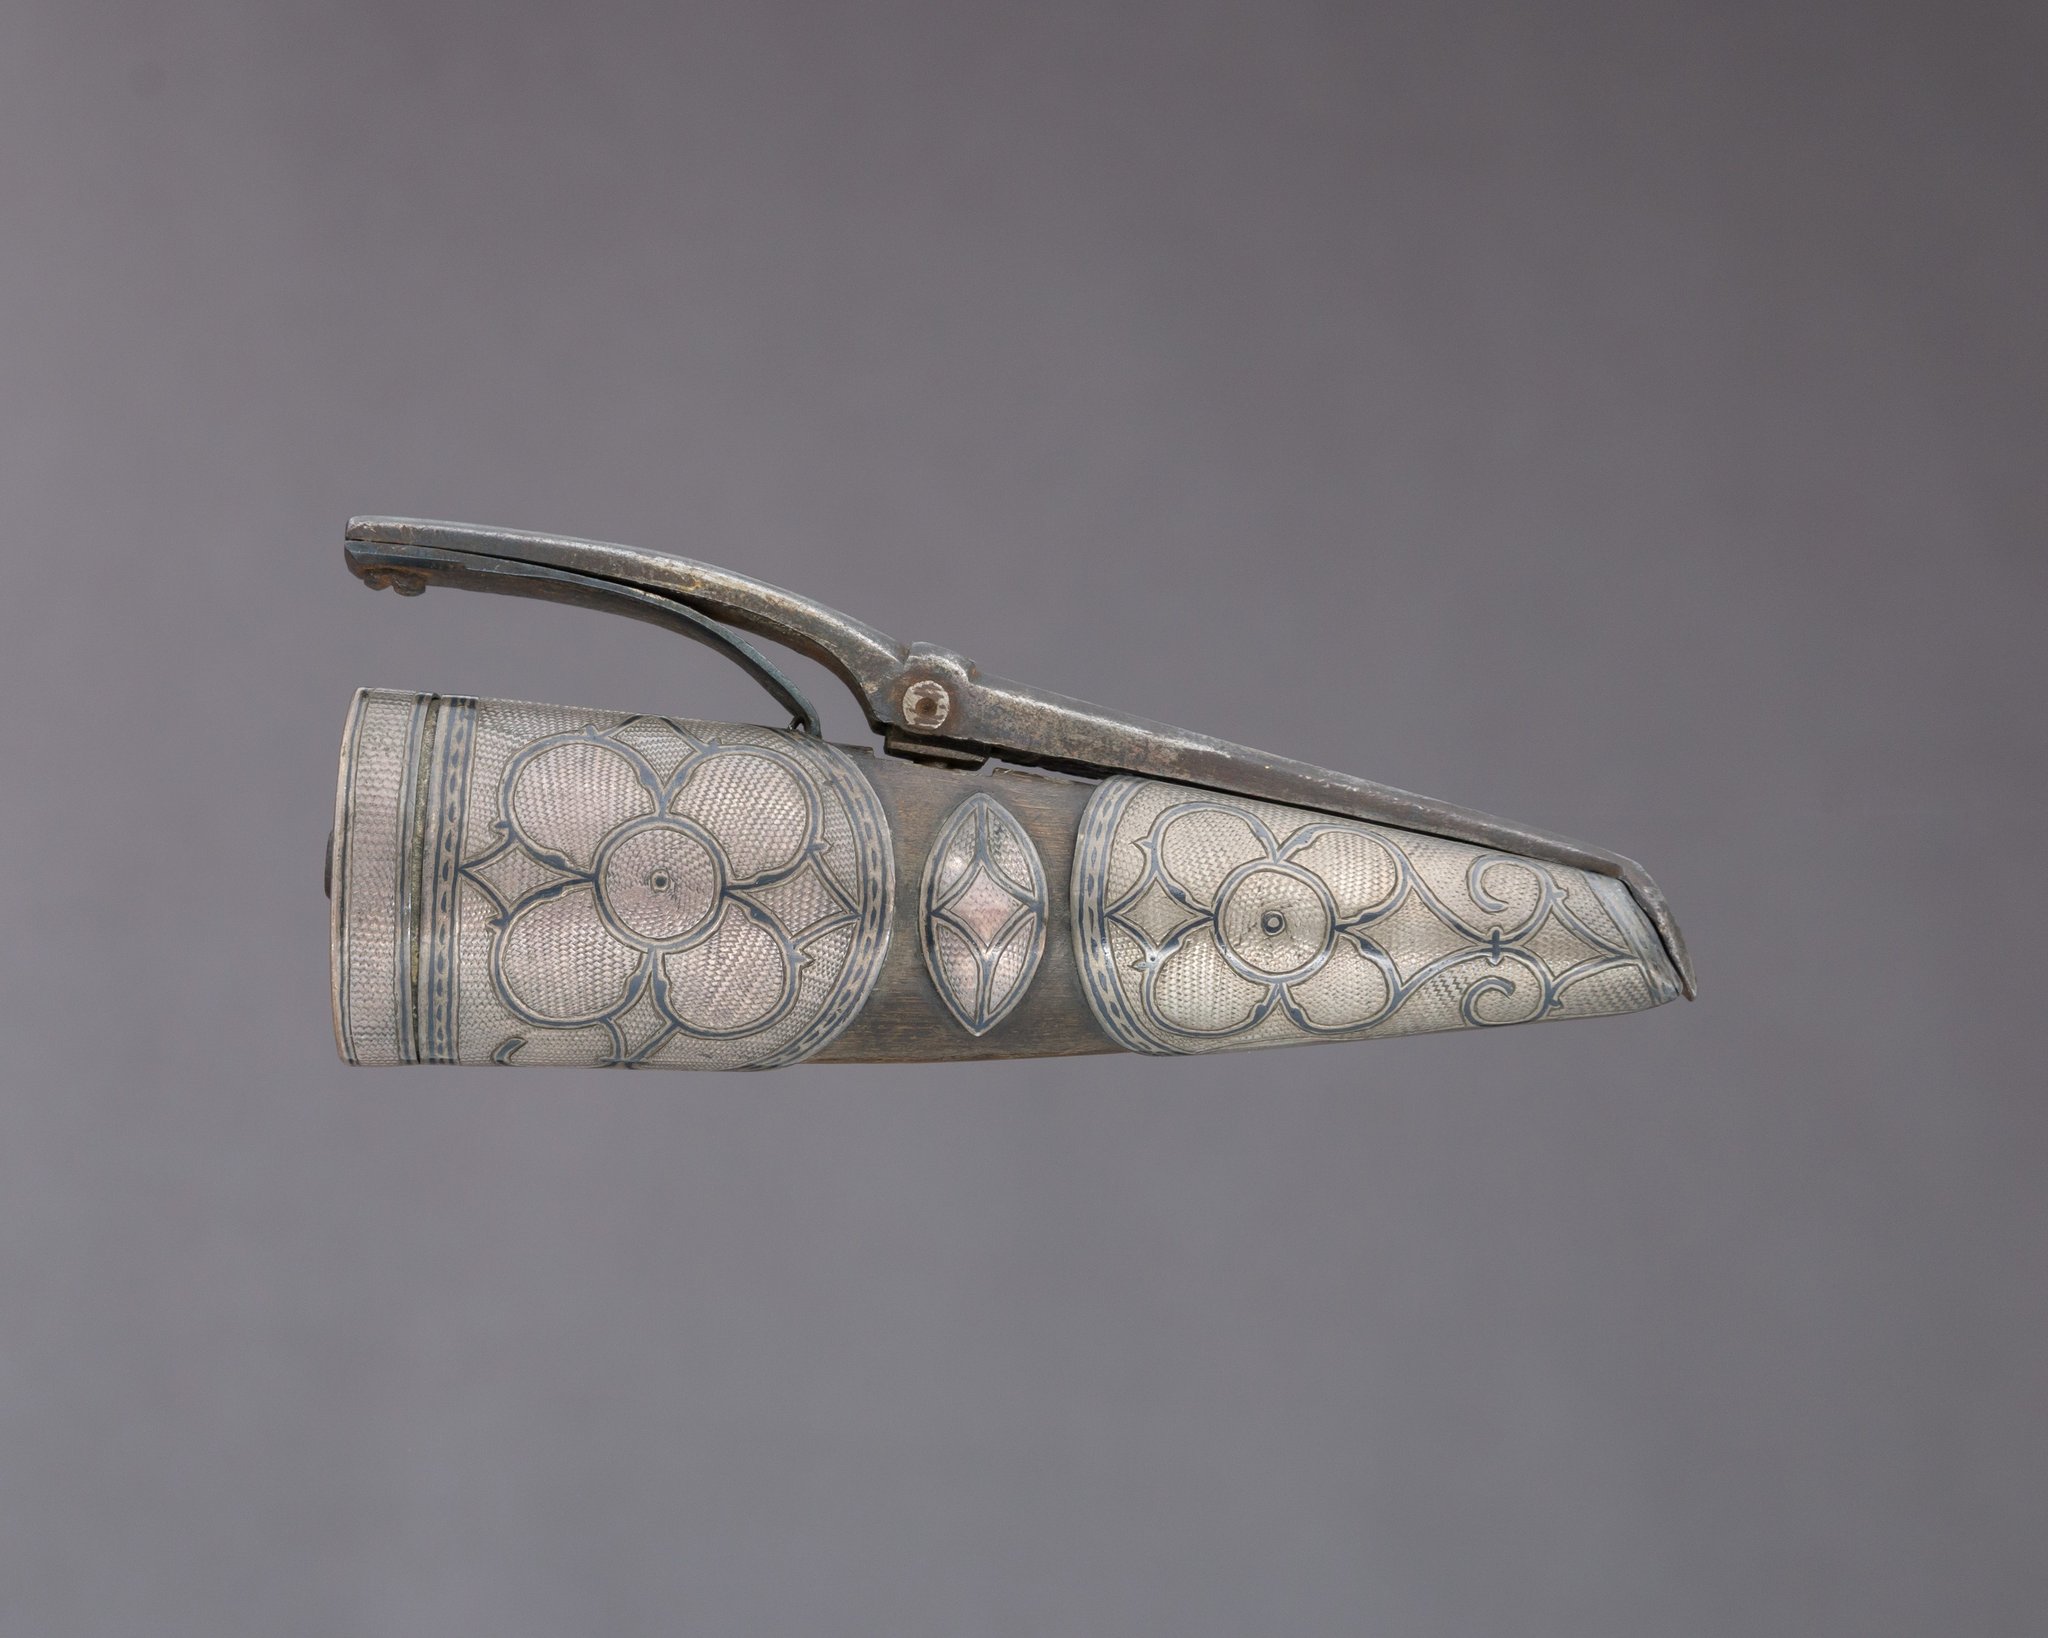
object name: primer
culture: caucasian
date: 1701-1900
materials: niello, silver, steel, wood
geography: caucasus